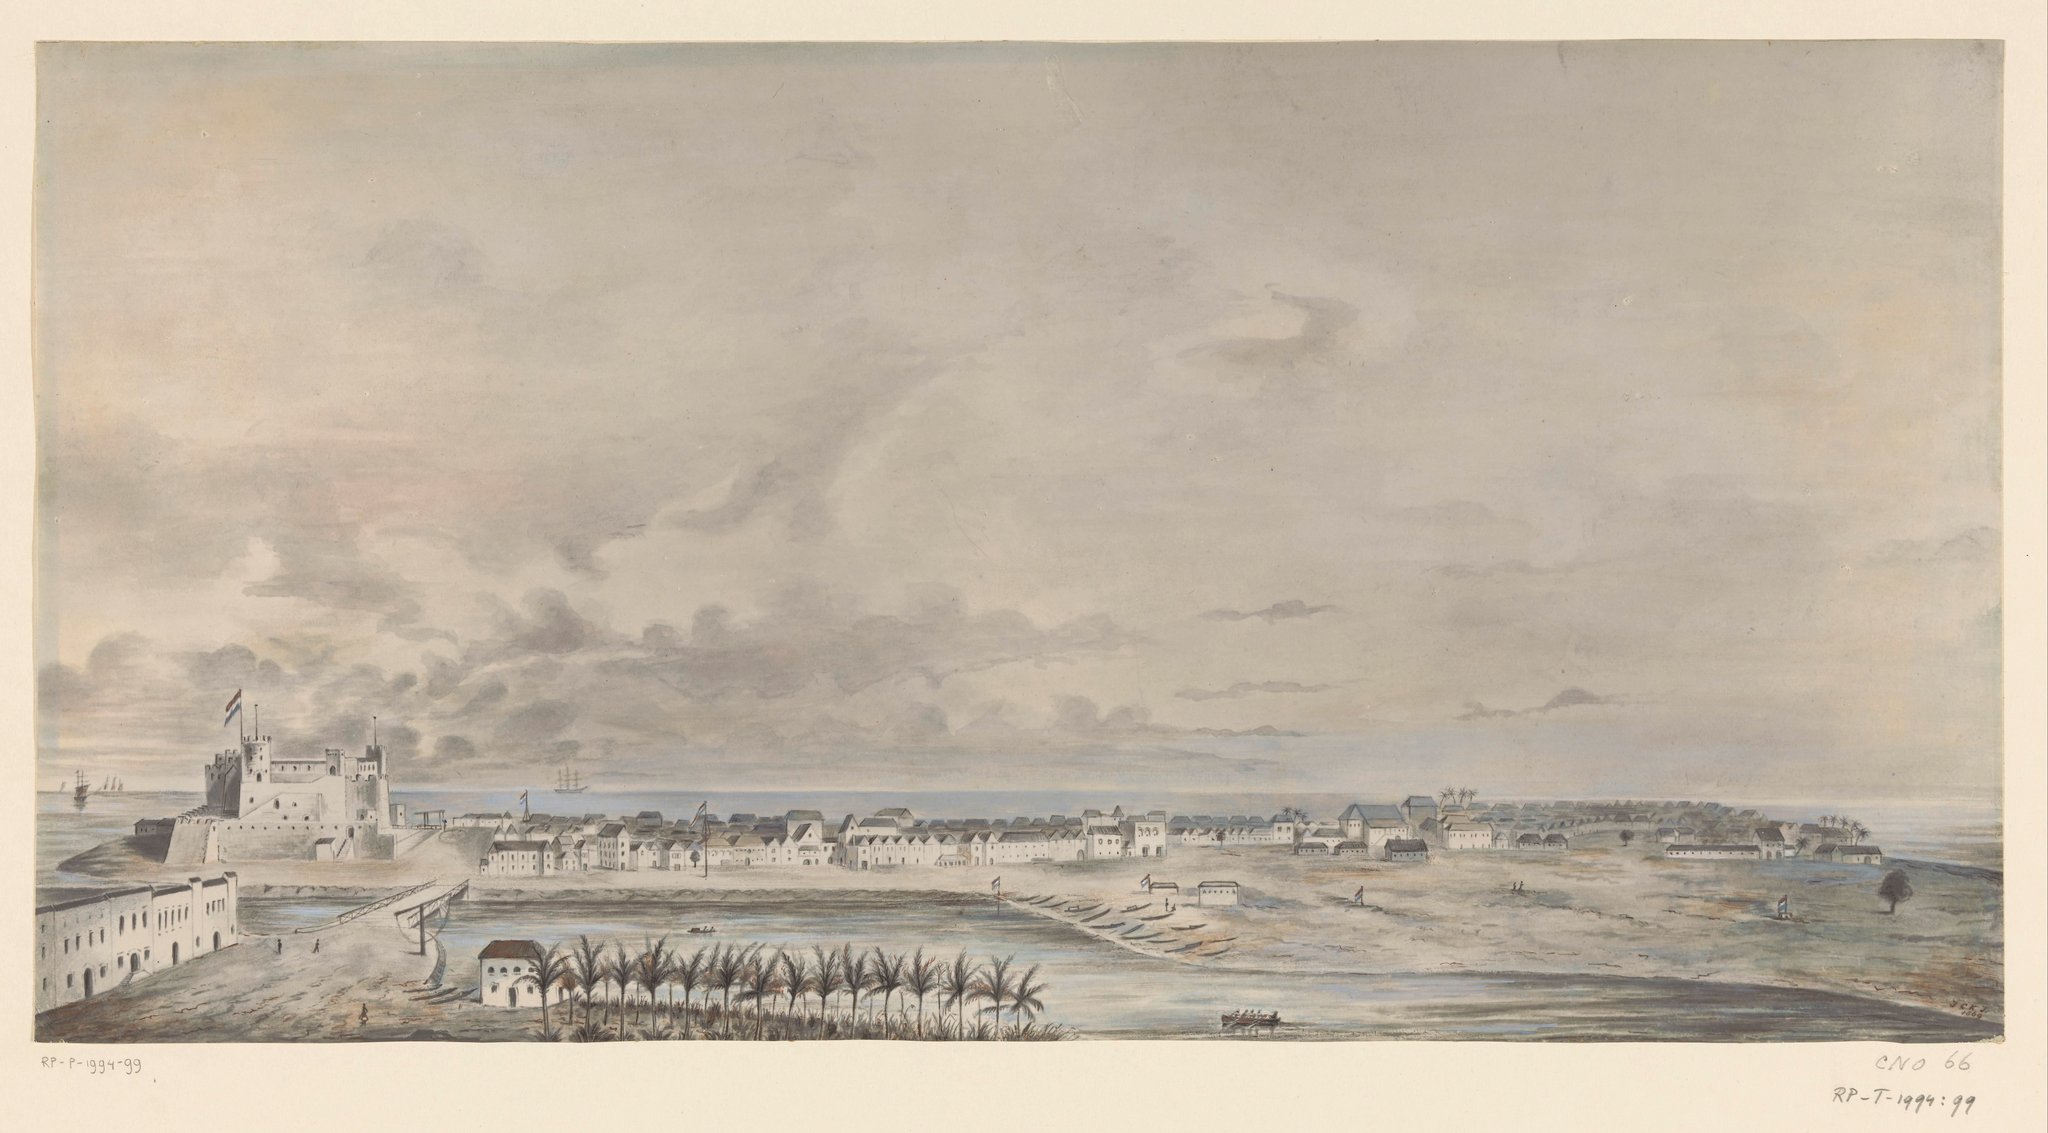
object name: drawing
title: Gezicht op Fort Elmina aan de kust van Ghana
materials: paint, ink, photographic support, watercolor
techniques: brush, pen, photography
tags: fortress, city-view in general; 'veduta', sea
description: Het betreft een foto van een tekening waar met waterverf en dekverf overheen is getekend.